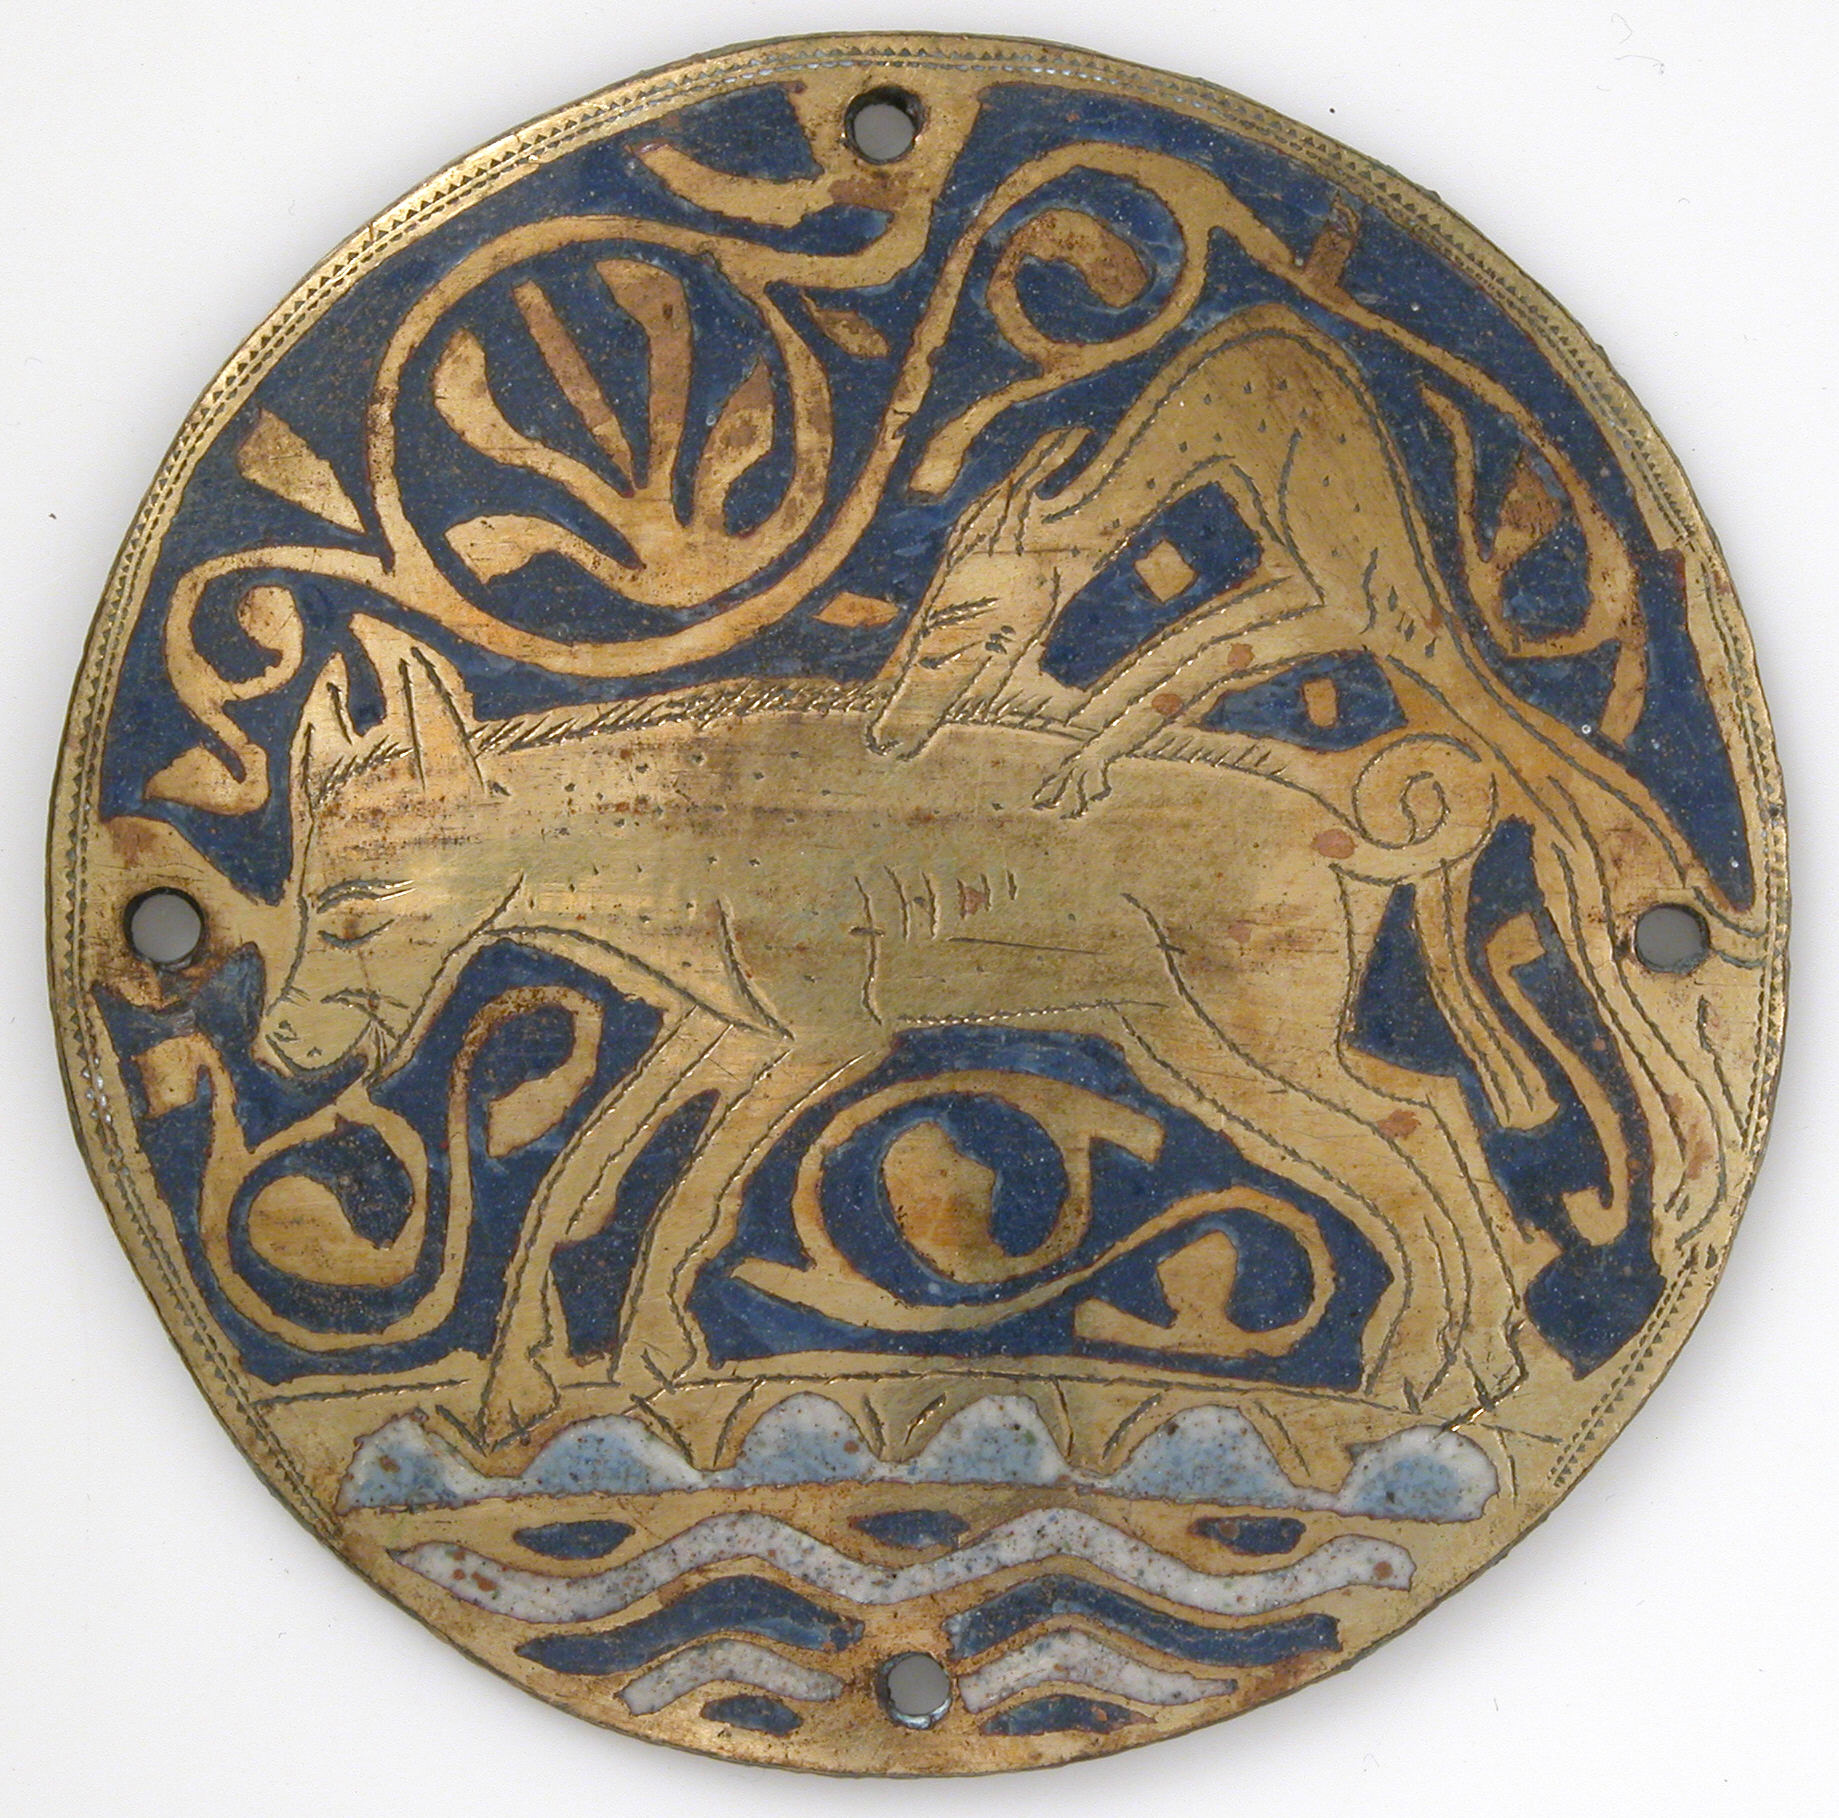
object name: medallion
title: Medallion with Hunting Dog Attacking Boar Crossing Water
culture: french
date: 1240-1260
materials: copper, enamel, gilt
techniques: enamel, engraving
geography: france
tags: hunting,boars,dogs